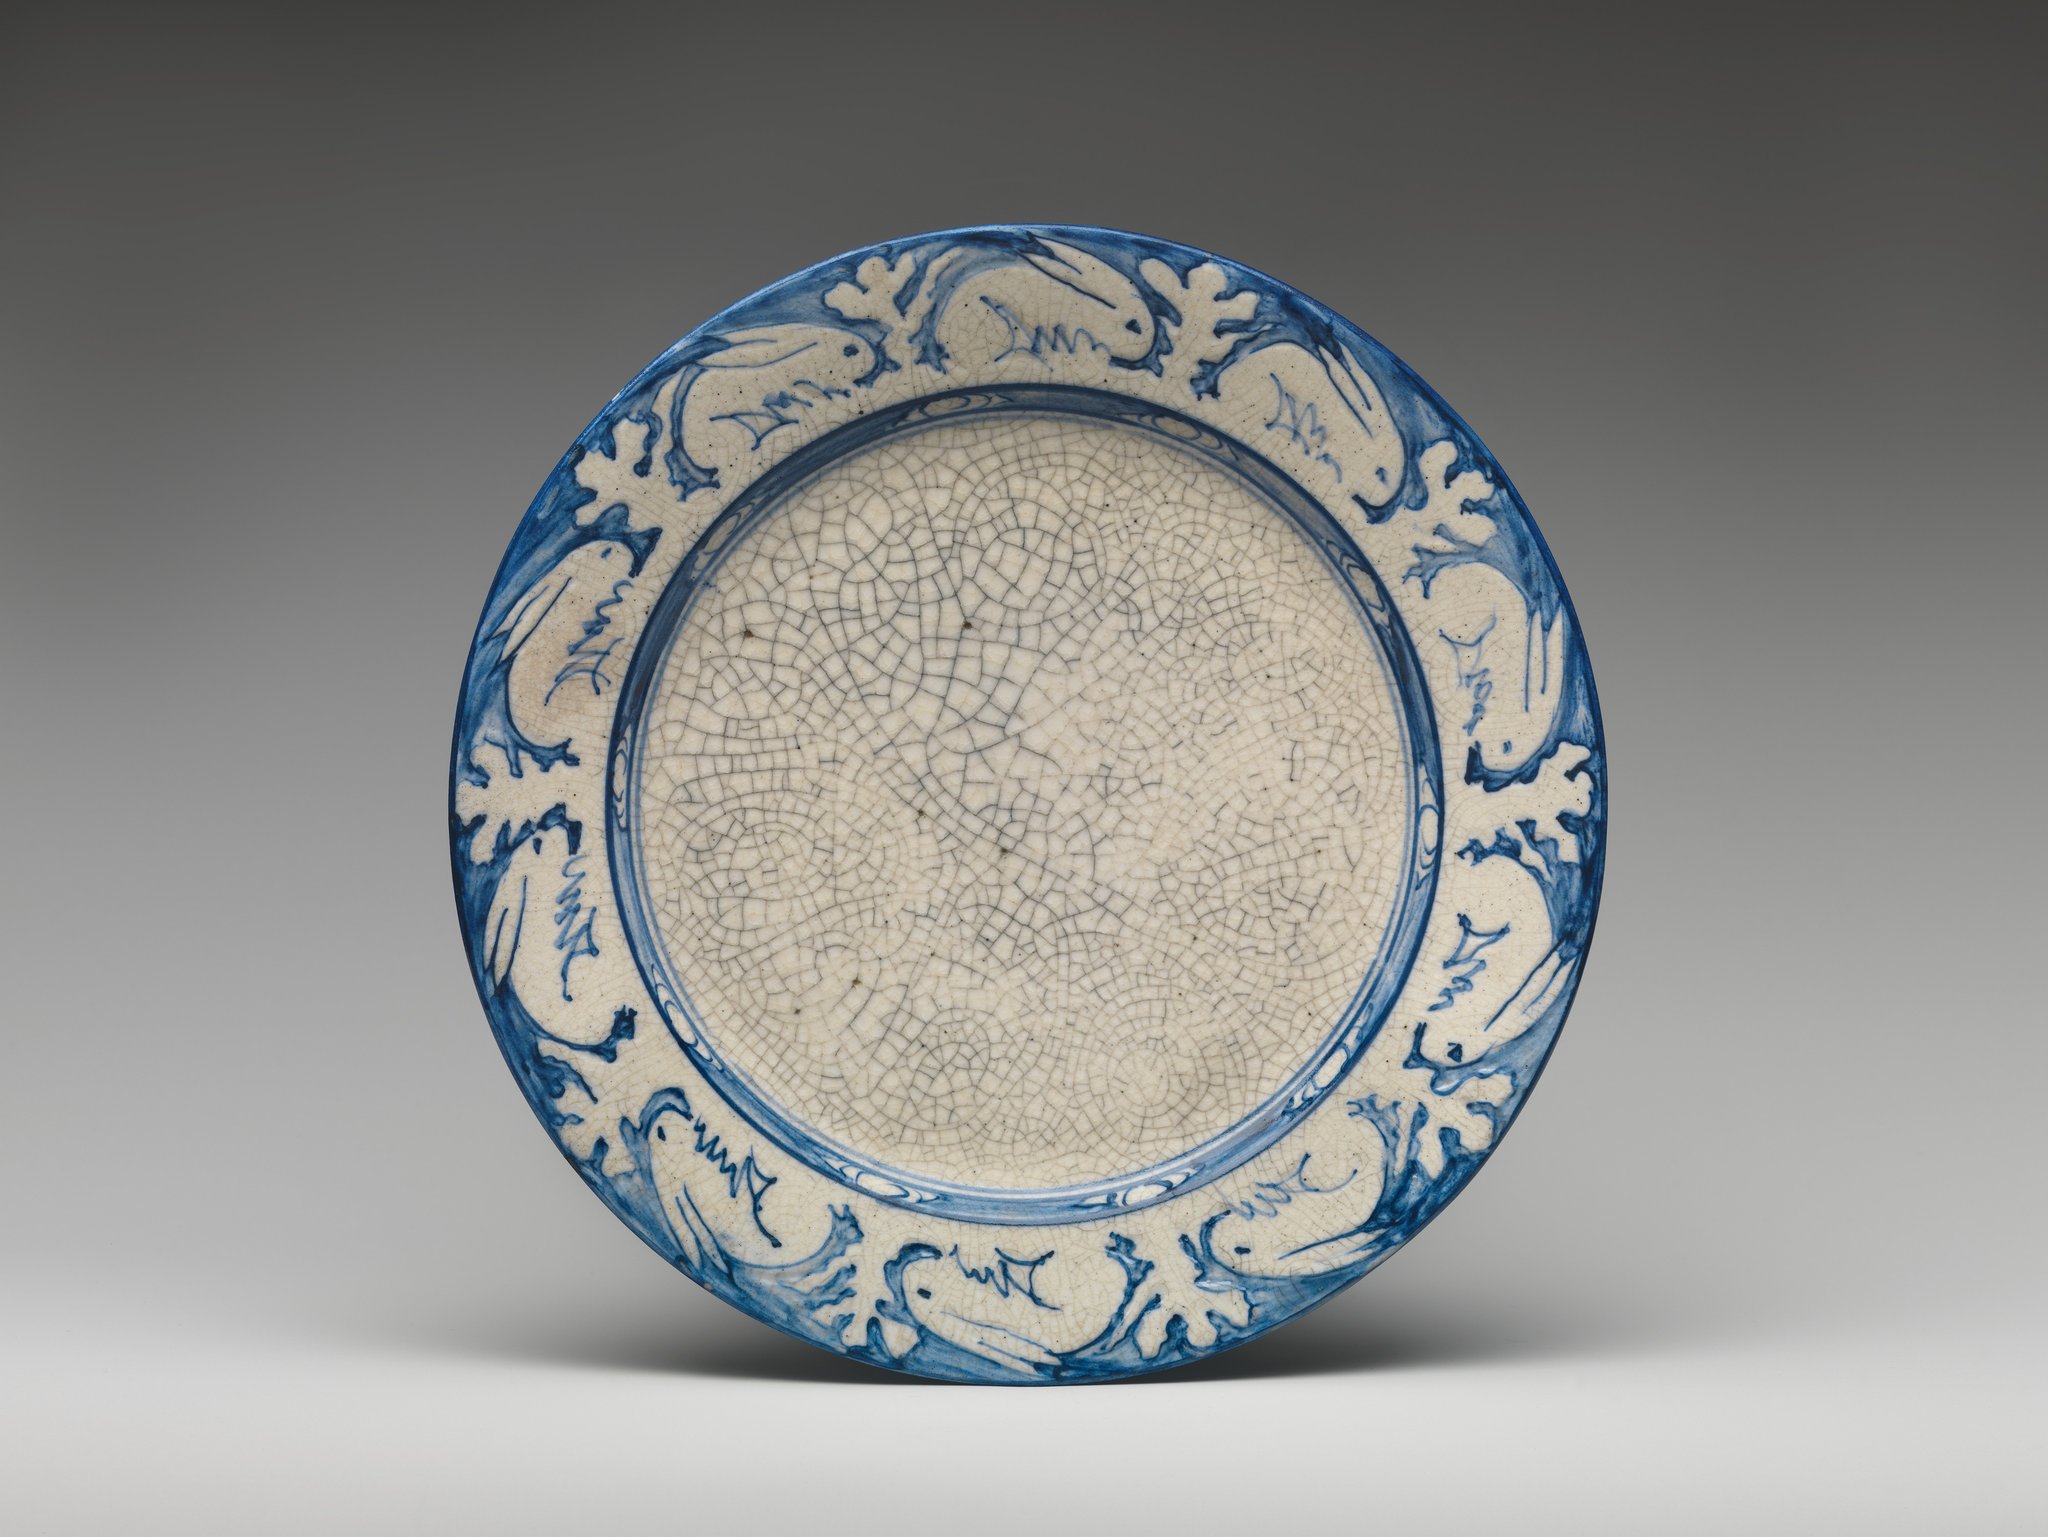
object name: plate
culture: american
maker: chelsea pottery u. s.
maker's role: maker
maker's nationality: american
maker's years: 1891-1895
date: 1891-1895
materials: earthenware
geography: united states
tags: rabbits